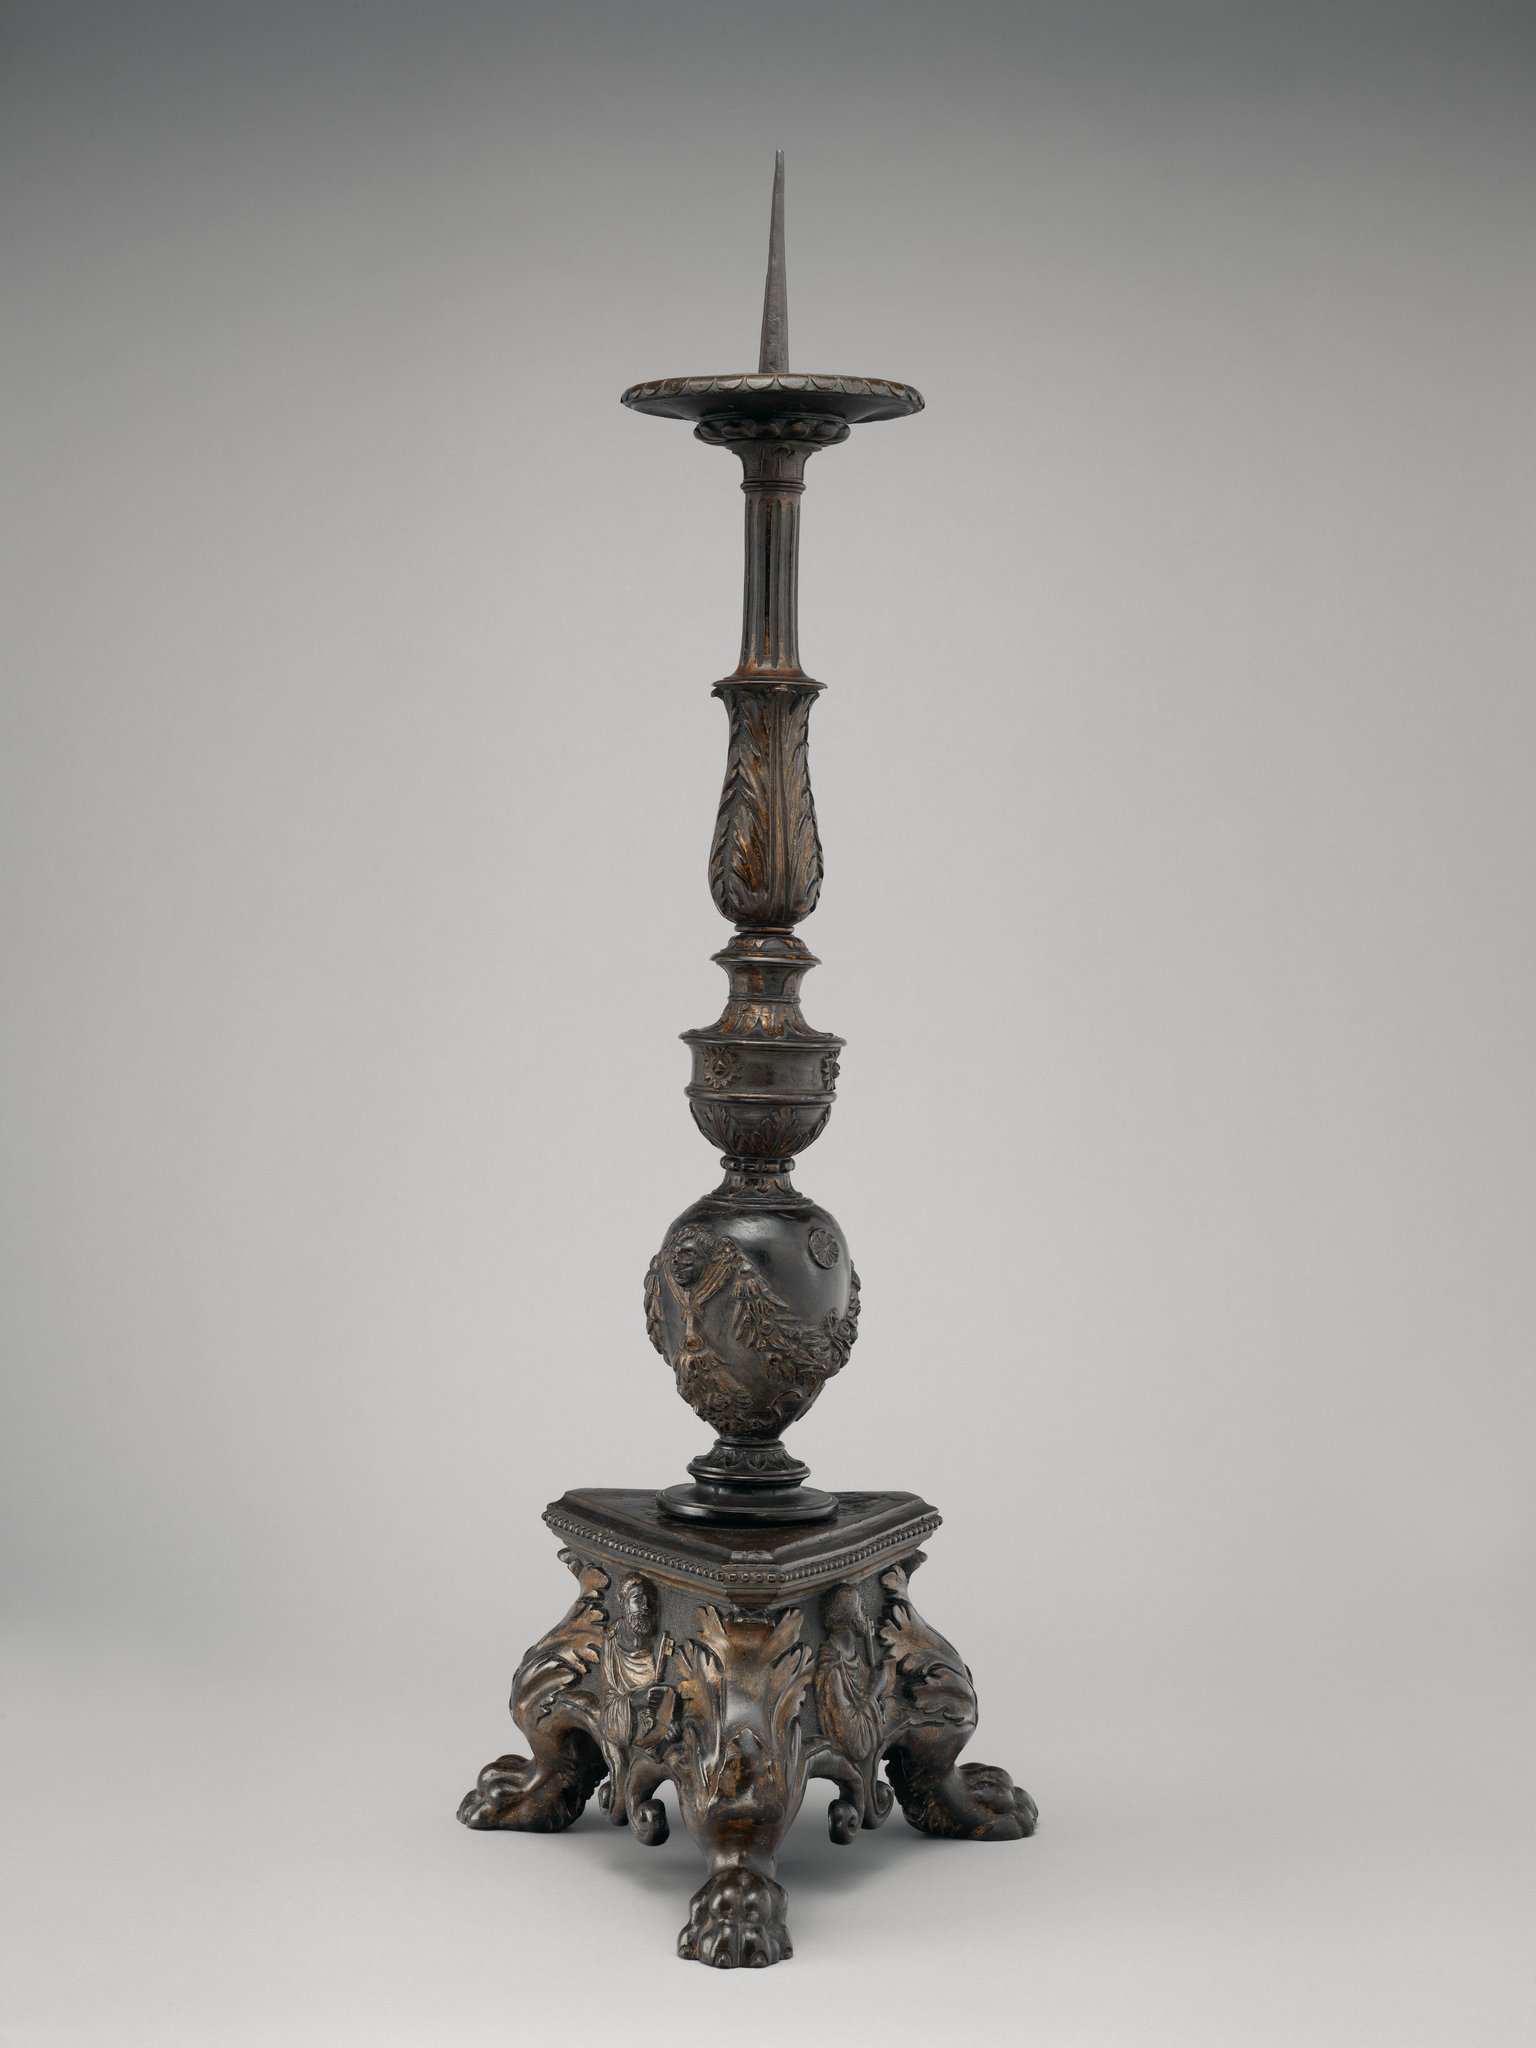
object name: candlestick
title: Altar candlestick with busts in relief of Saints Peter and Paul (one of a pair)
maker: vincenzo grandi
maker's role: artist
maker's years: 1507-1578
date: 1534-1566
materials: bronze, gilt, oil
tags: saint matthew